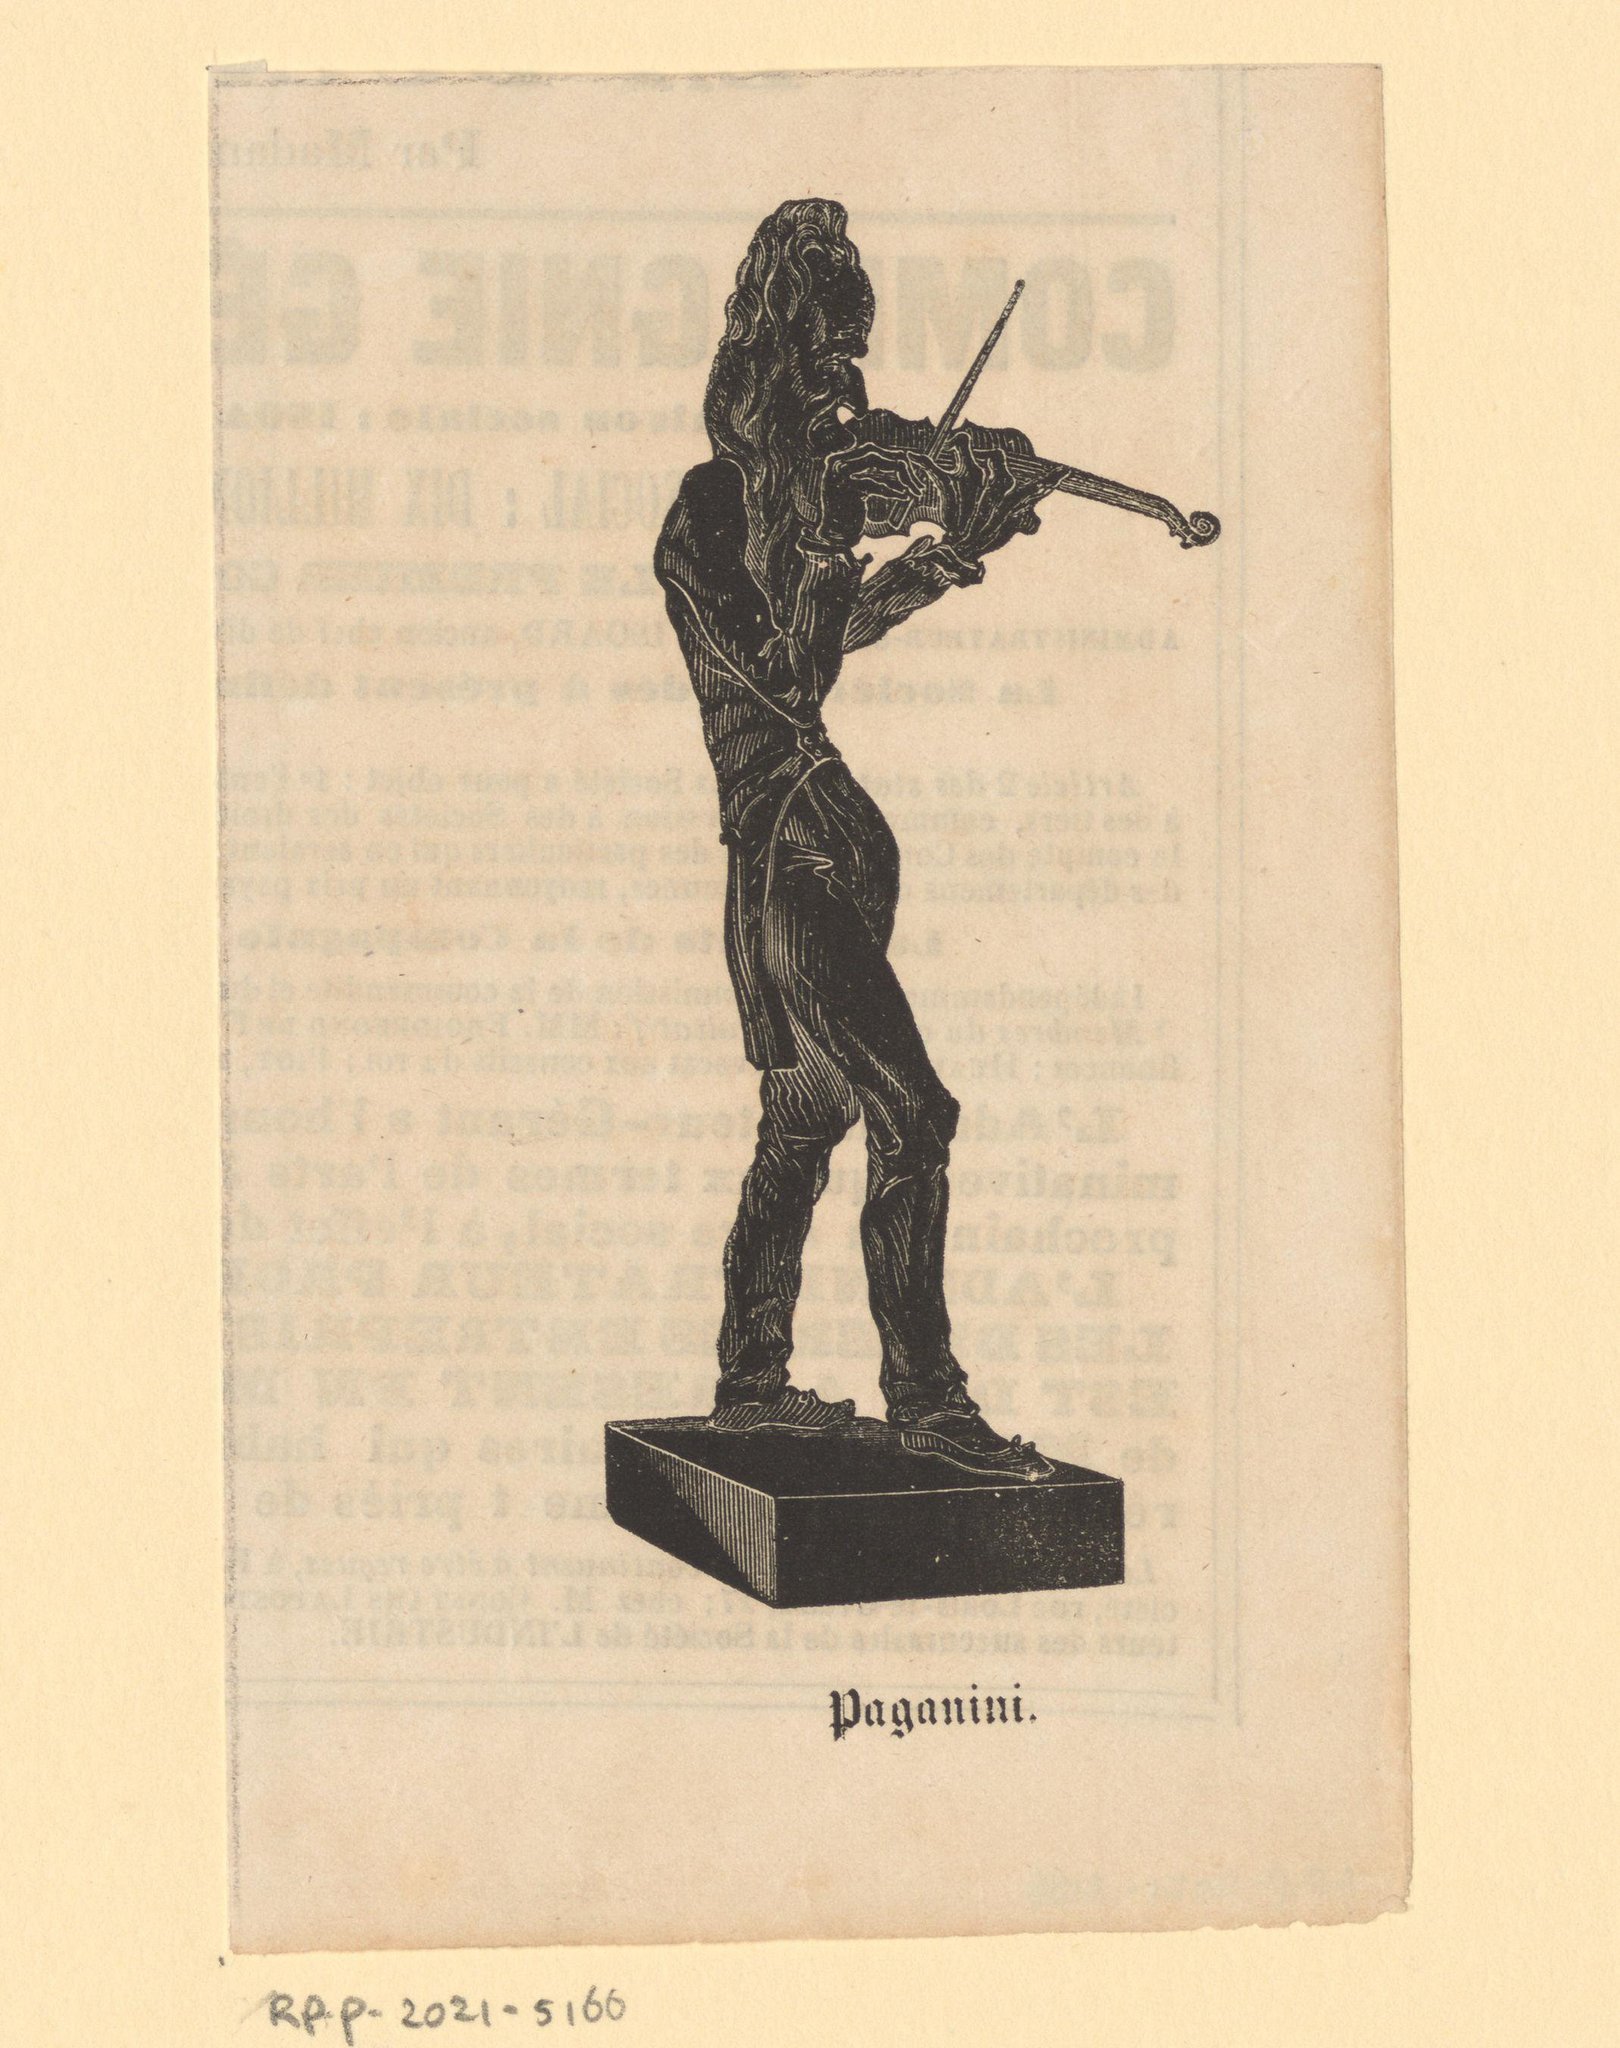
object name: print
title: Portret van Niccolò Paganini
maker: Anonymous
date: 1810-1899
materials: paper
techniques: letterpress printing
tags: adult man, historical persons, violin, fiddle, portrait of a musician